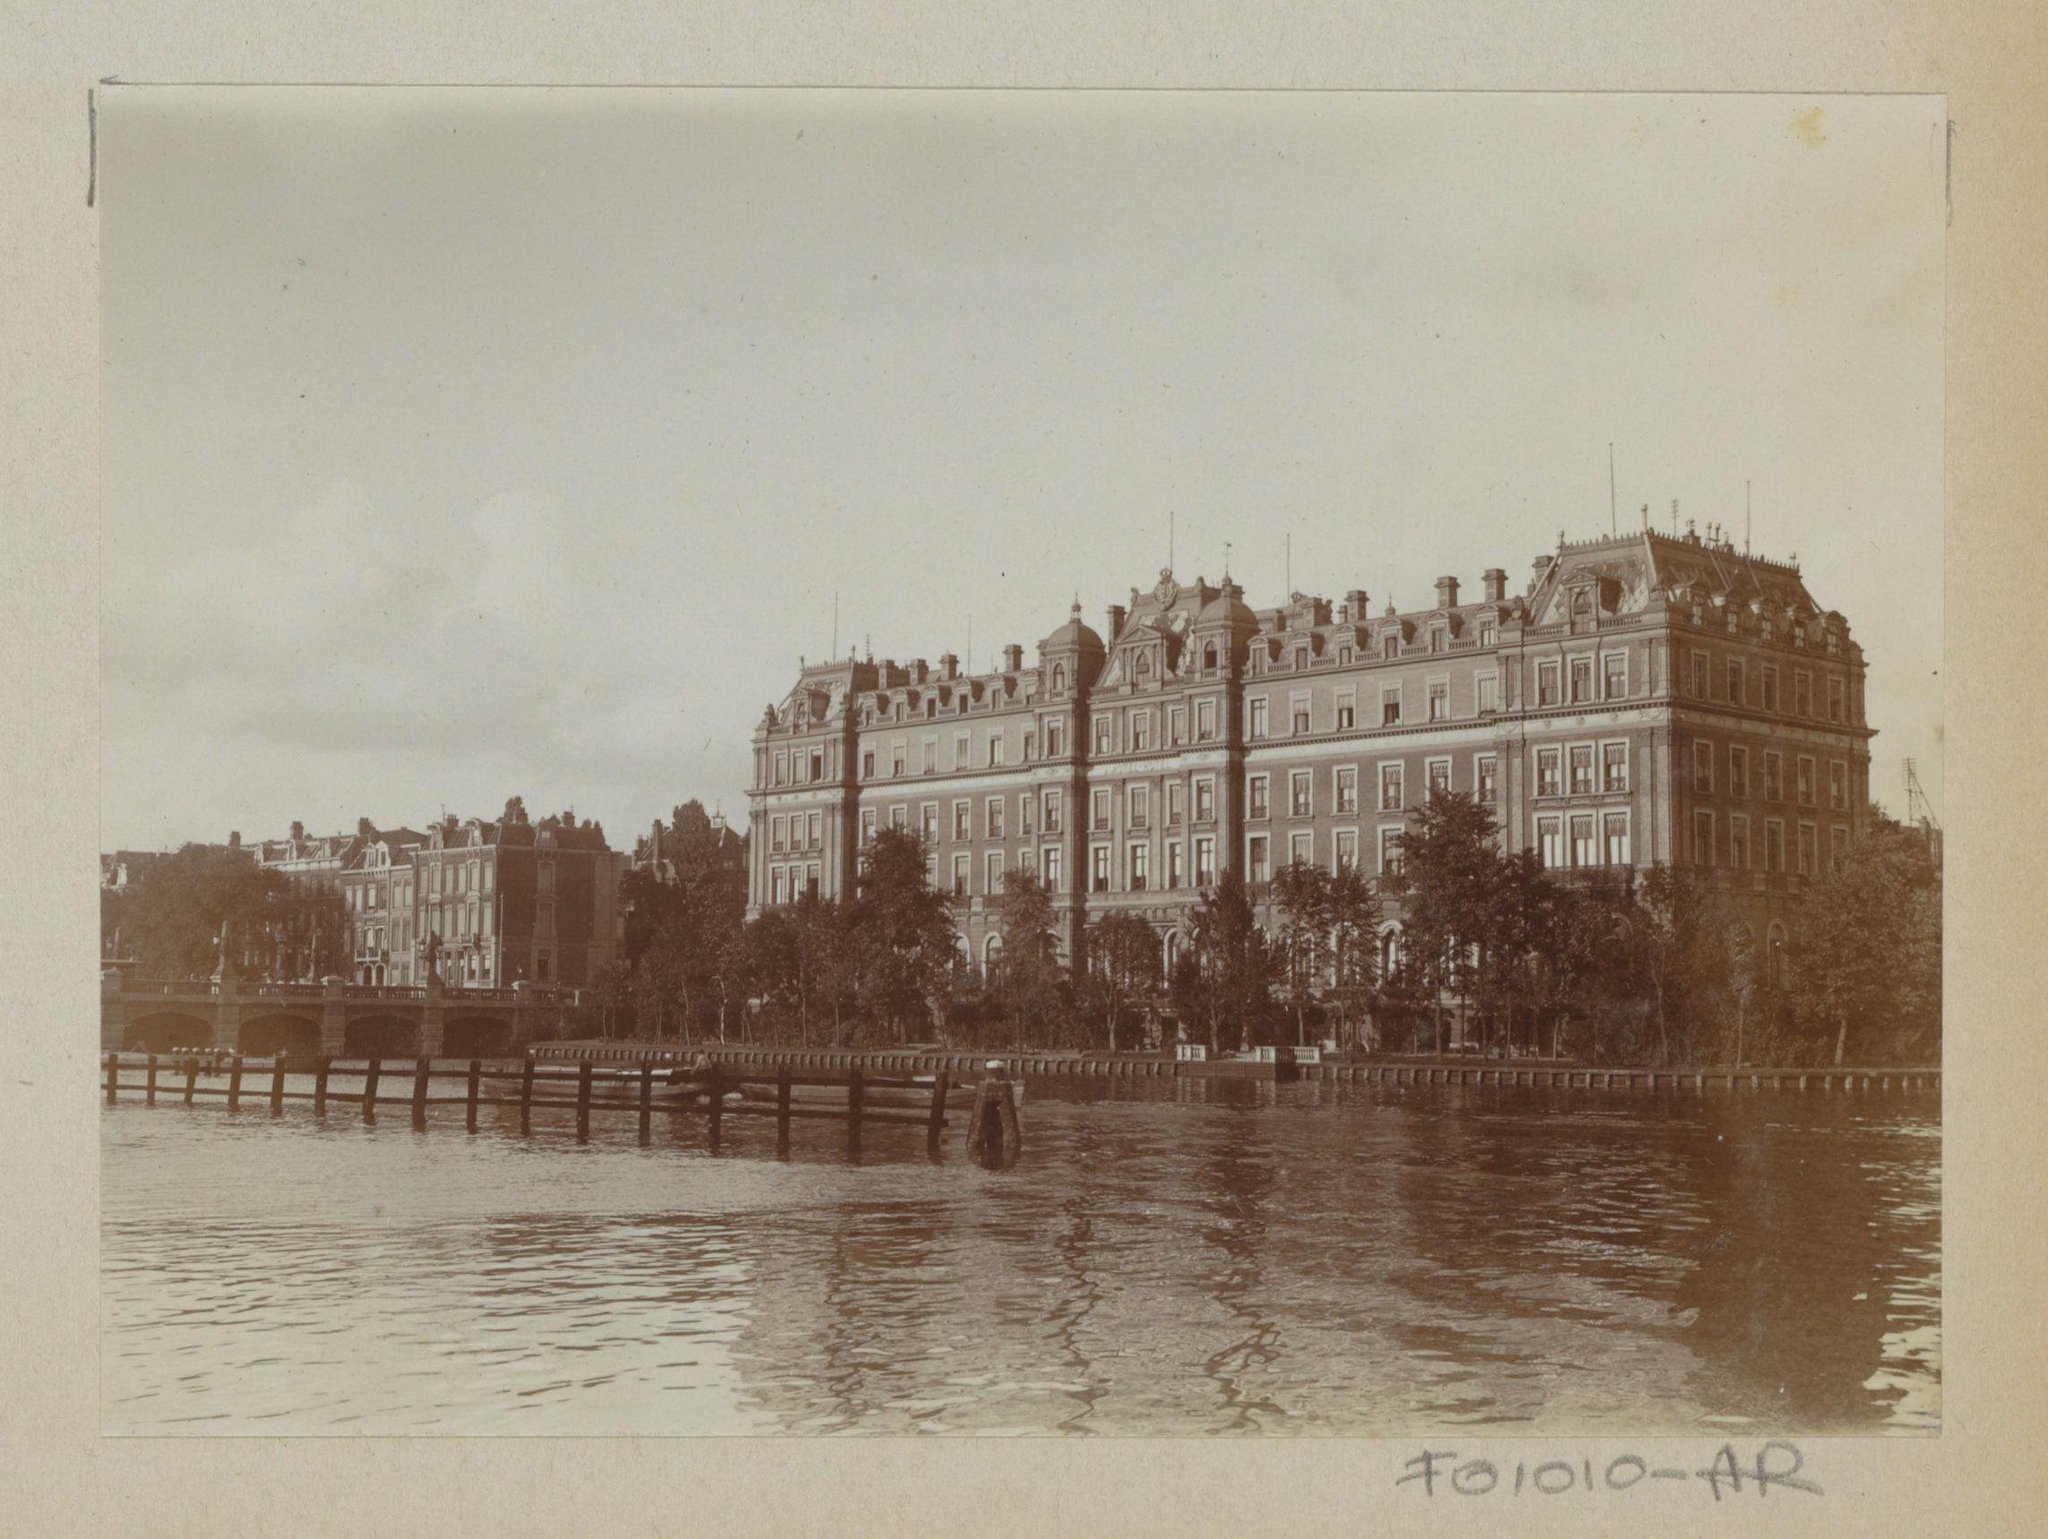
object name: photograph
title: Gezicht op het Amstel Hotel in Amsterdam, op de voorgrond de Amstel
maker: Anonymous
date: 1900-1910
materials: photographic support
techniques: daylight paper print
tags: river, hotel, hostelry, inn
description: Onderdeel van Familiealbum met onder meer foto's van Wijnhandel Kraaij & Co. Bordeaux-Amsterdam.